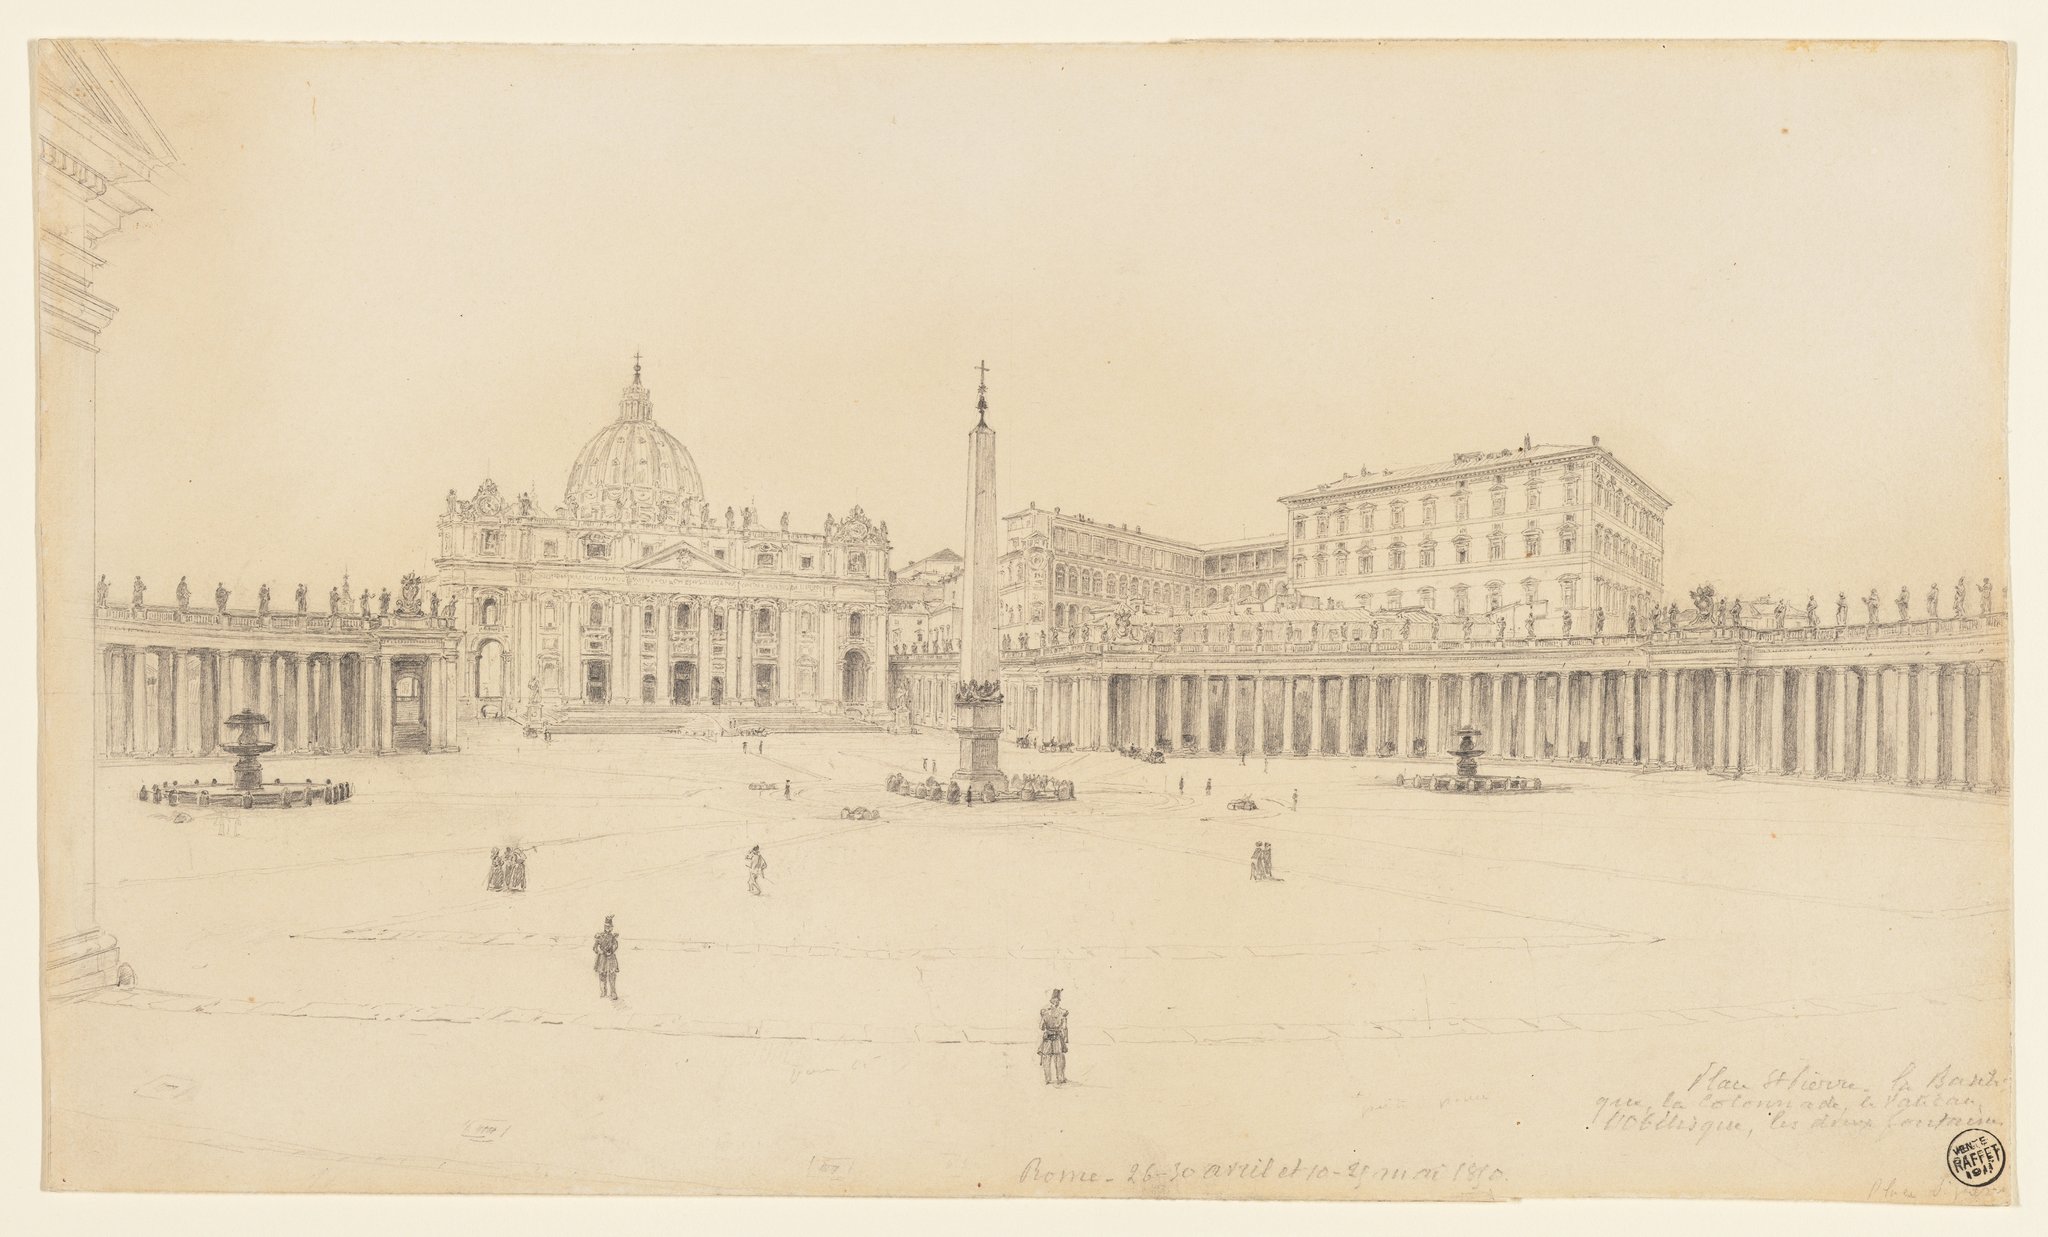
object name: drawing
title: View of St. Peter’s Square, Rome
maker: auguste raffet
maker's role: artist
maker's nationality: french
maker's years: 1804-1860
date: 1850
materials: graphite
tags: rome